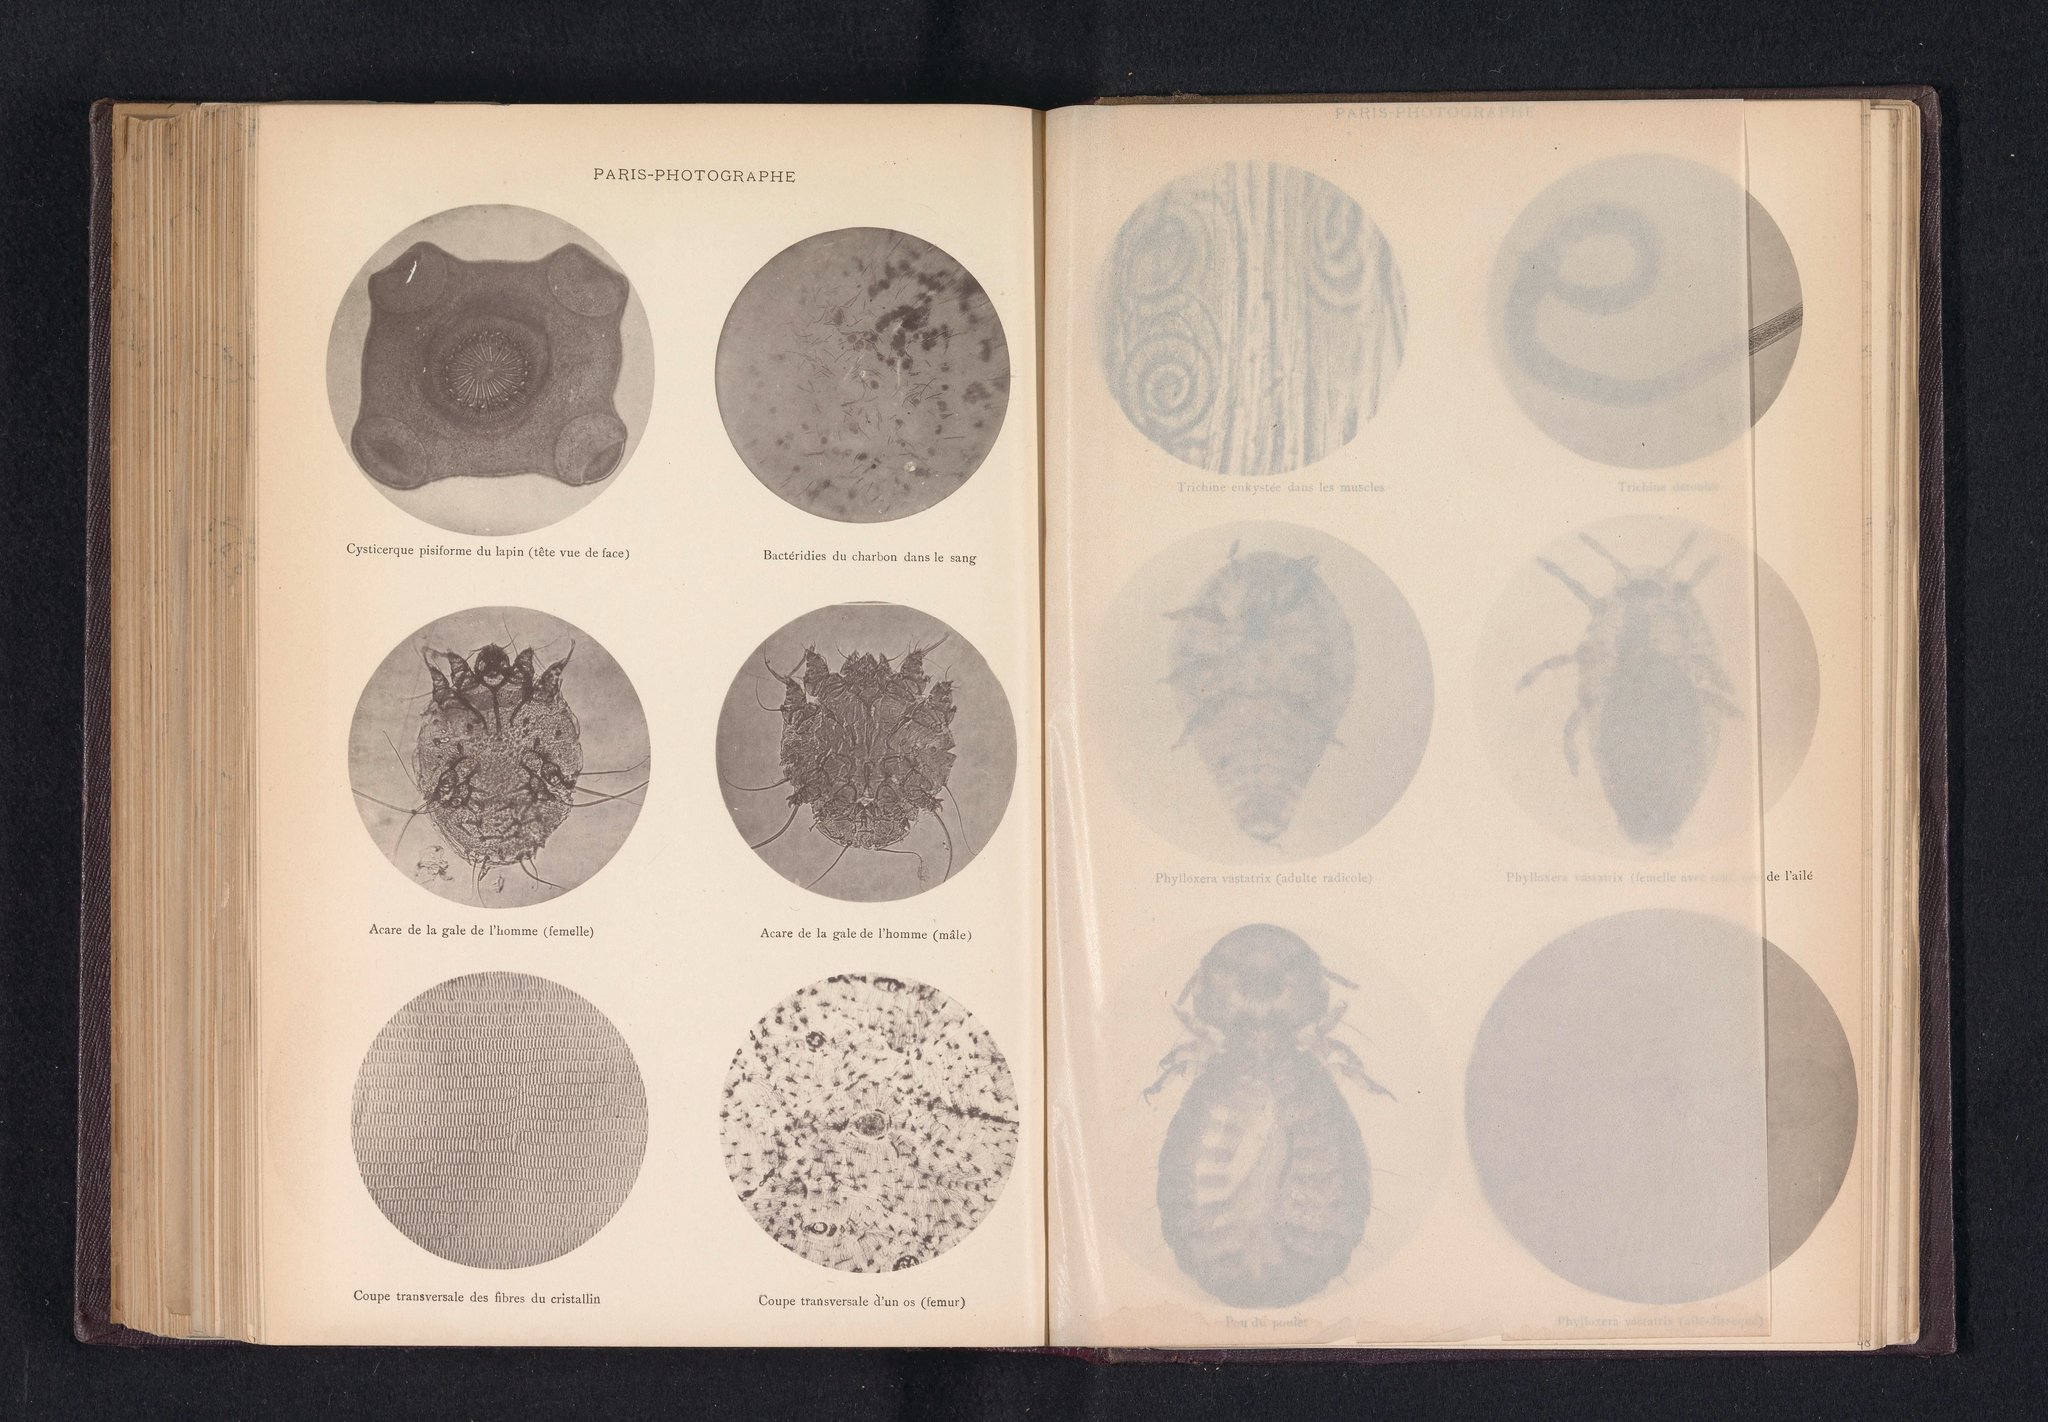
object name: photomechanical print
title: Overzicht van zes microscopische vergrotingen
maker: Anonymous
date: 1881-1891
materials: paper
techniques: photograph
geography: france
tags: unicellular animals, bacteria, bacilli, bones of the legs, microscope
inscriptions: inscription: ‘Cysticerque pisiforme (...) Coupe transversale d'un os (femur)’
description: Boven een cysticercus en een bacterie, midden een schurftbacterie, onder een deel van de ooglens en een deel van het dijbeen.